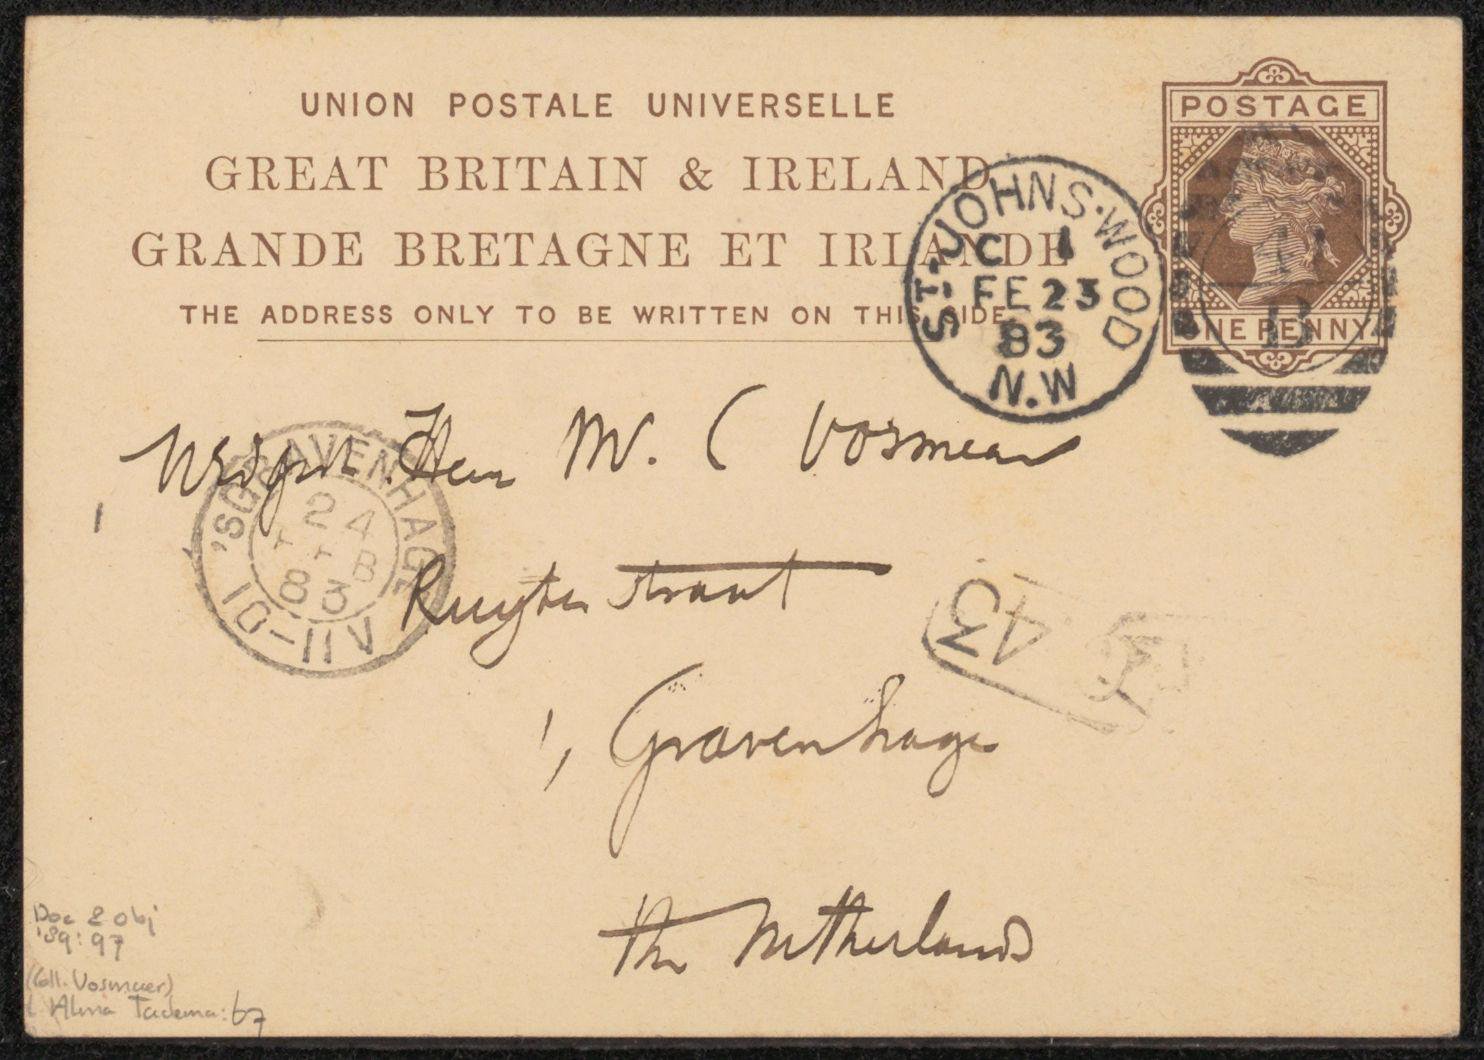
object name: postcard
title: Briefkaart aan Carel Vosmaer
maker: lourens alma tadema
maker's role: draughtsman, print maker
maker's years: 1836-1912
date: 1883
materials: cardboard, ink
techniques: pen, writing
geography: london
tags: rome, sculptor, carel vosmaer, literature ~ arts, workshop, studio of the artist (in general), paris